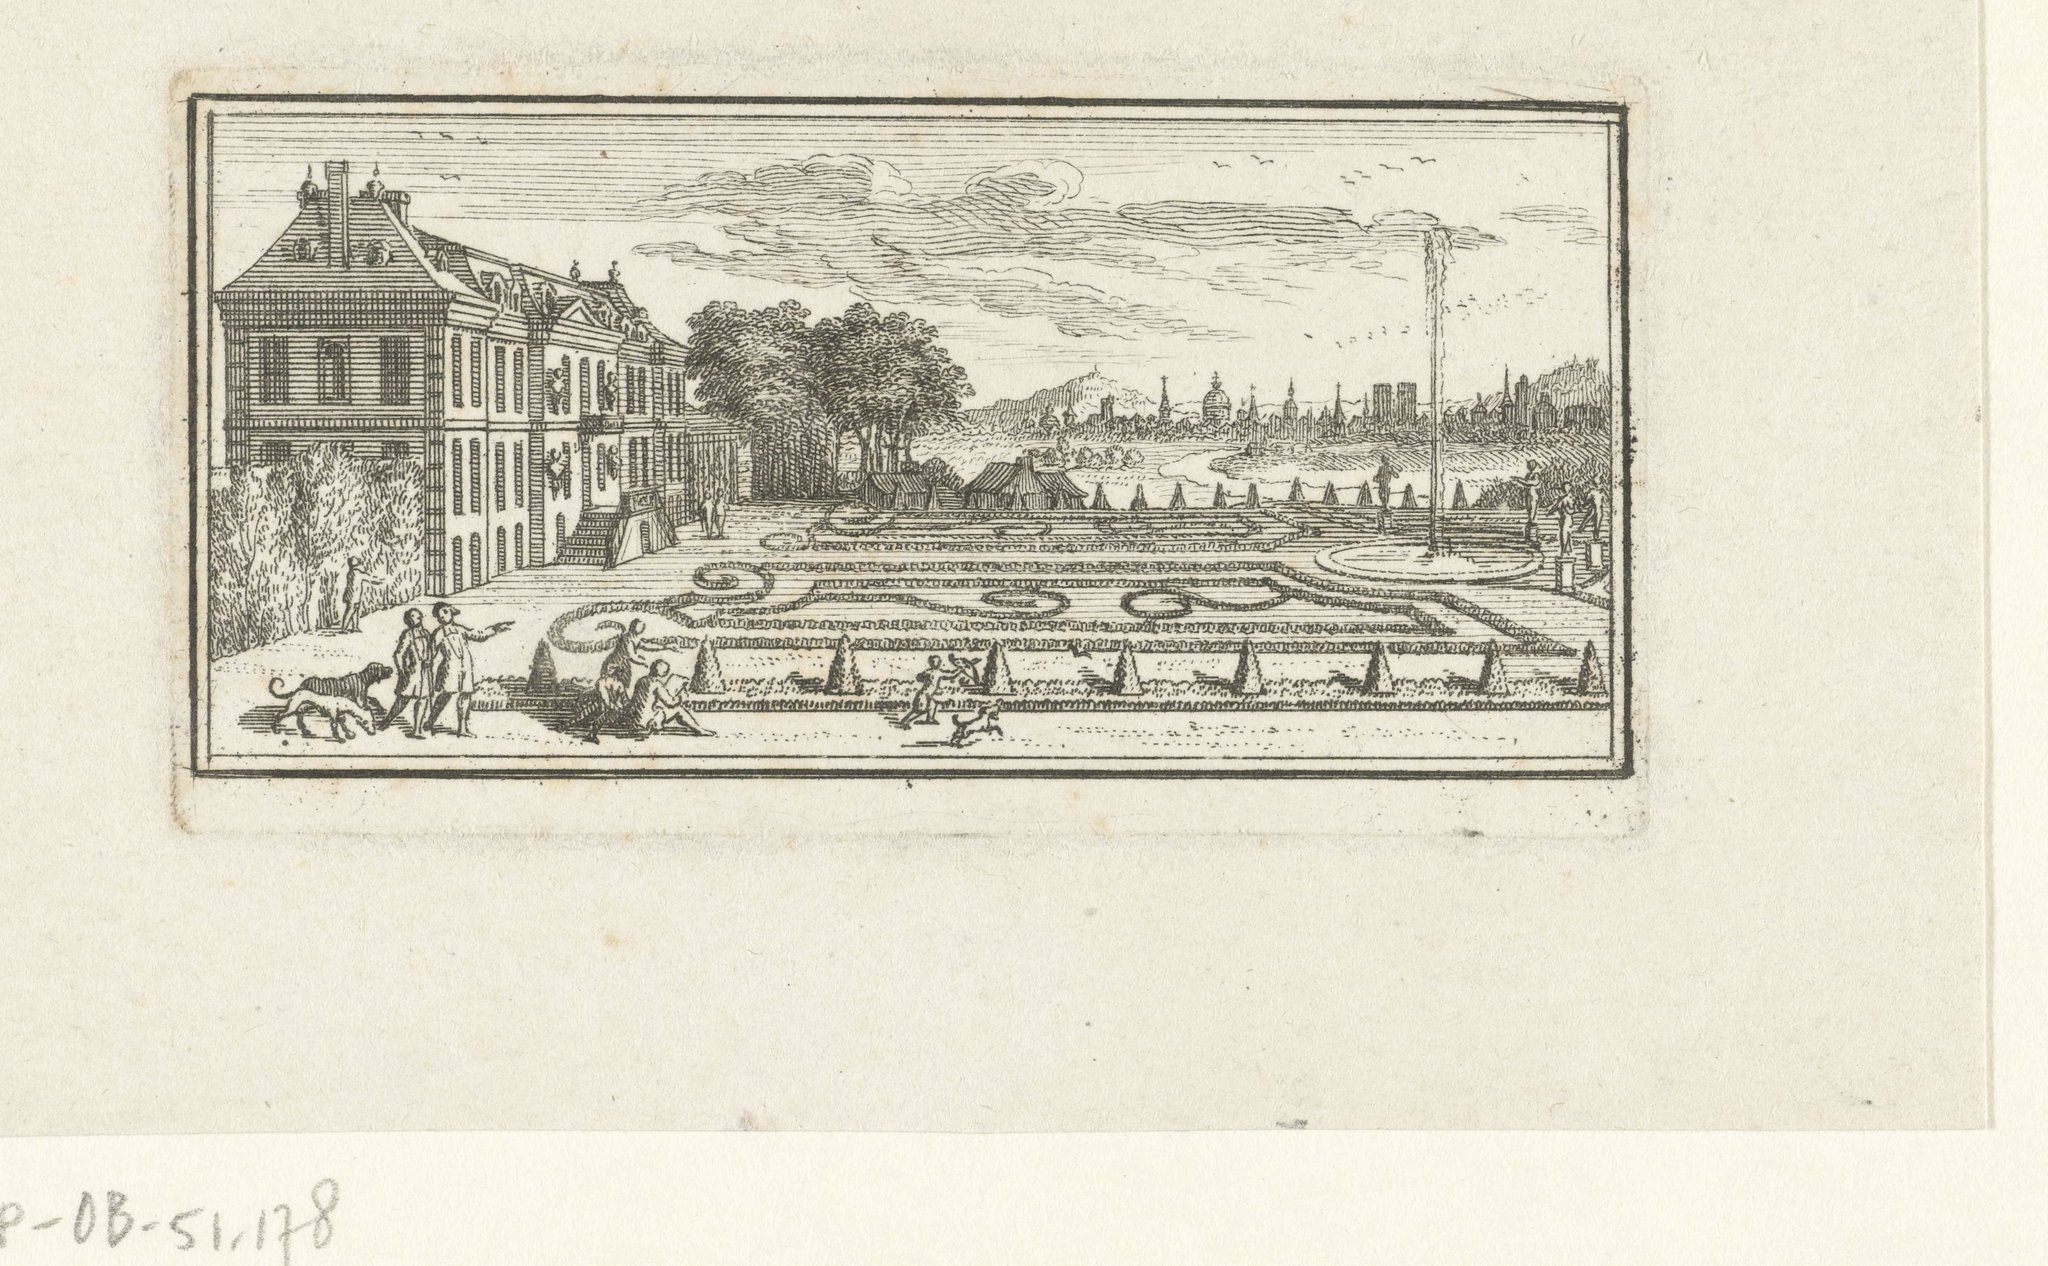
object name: print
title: Gezicht op een landhuis en tuin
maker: bernard picart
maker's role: draughtsman, print maker, publisher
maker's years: 1673-1733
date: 1683-1733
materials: paper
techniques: etching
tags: rural housing, e.g. country-house, villa, cottage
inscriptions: collector's mark: Lugt 2228